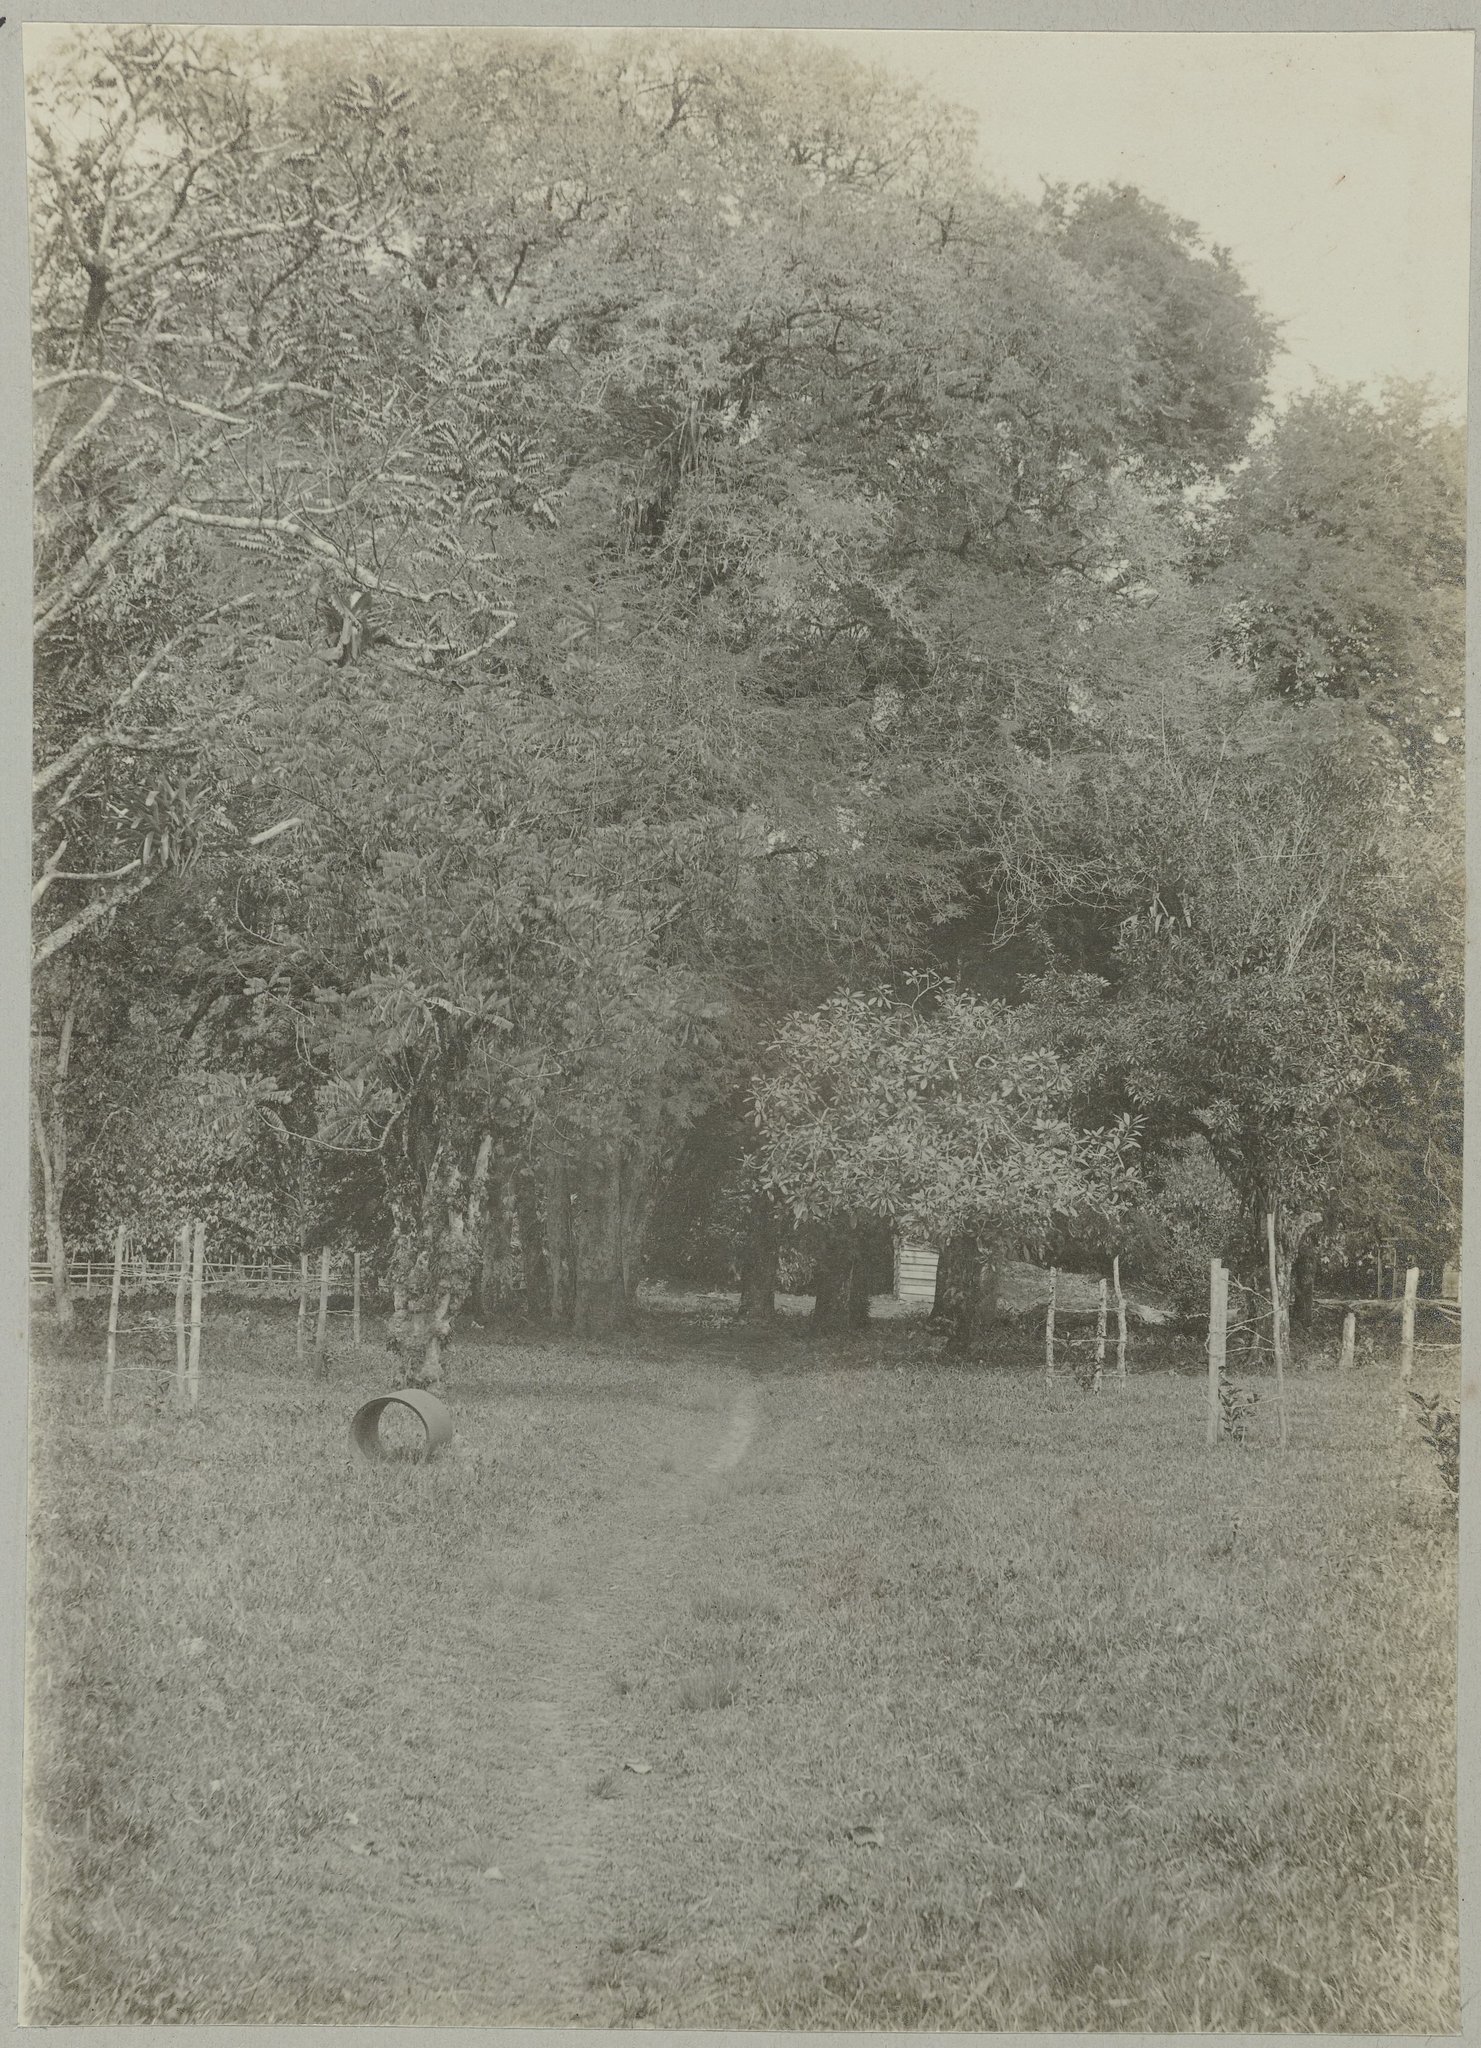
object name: photograph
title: Tamarindegroepen op Tourtonne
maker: hendrik doijer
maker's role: engineer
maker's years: 1863-1925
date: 1903-1910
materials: photographic support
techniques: gelatin silver print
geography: suriname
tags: suriname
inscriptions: inscription: ‘C12 / Tamarindegroepen op Tourtonne.’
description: Groepen hoge tamarindebomen op de plantage Tourtonne. Onderdeel van het fotoalbum Souvenir de Voyage (deel 2), over het leven van de familie Doijer in en rond de plantage Ma Retraite in Suriname in de jaren 1903-1910.